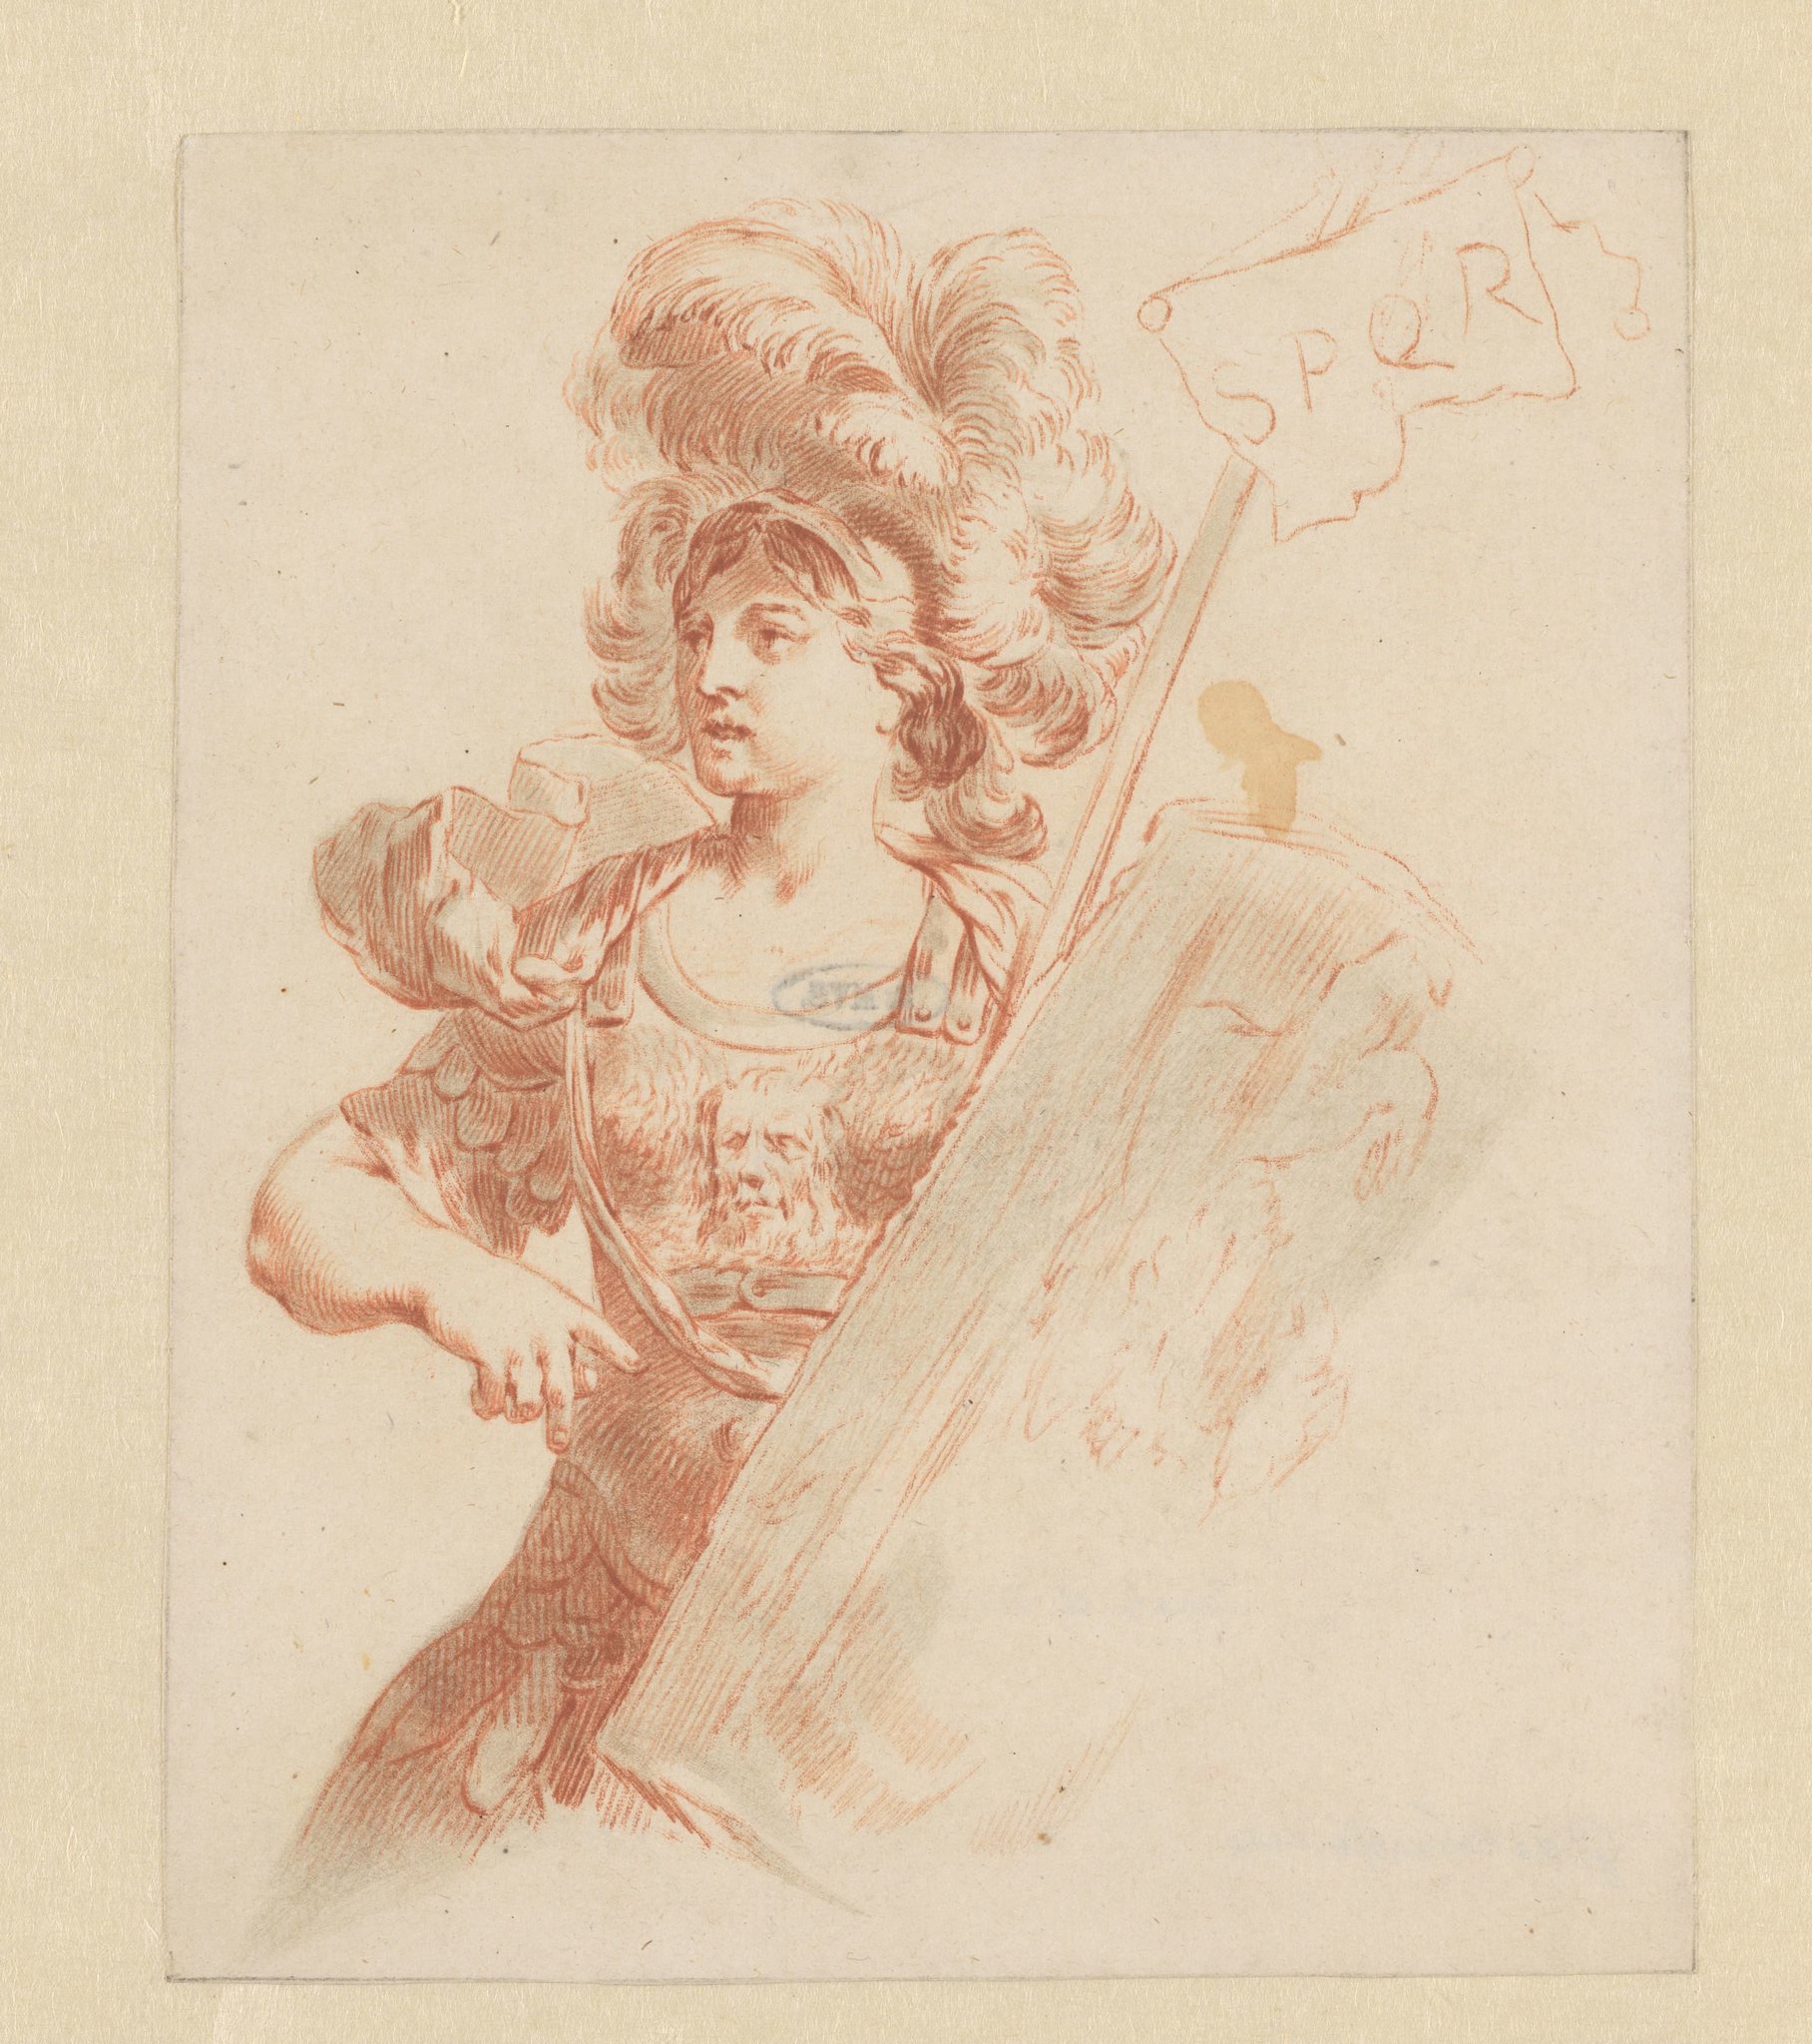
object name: print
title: Kracht (Fortitudo)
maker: izaak jansz. de wit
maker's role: draughtsman, print maker, publisher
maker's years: 1744-1809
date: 1754-1809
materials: paper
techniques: printmaking, etching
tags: fortitude, 'fortitudo' ~ one of the four cardinal virtues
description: Meisjesfiguur met helm en in de linkerhand een schild.